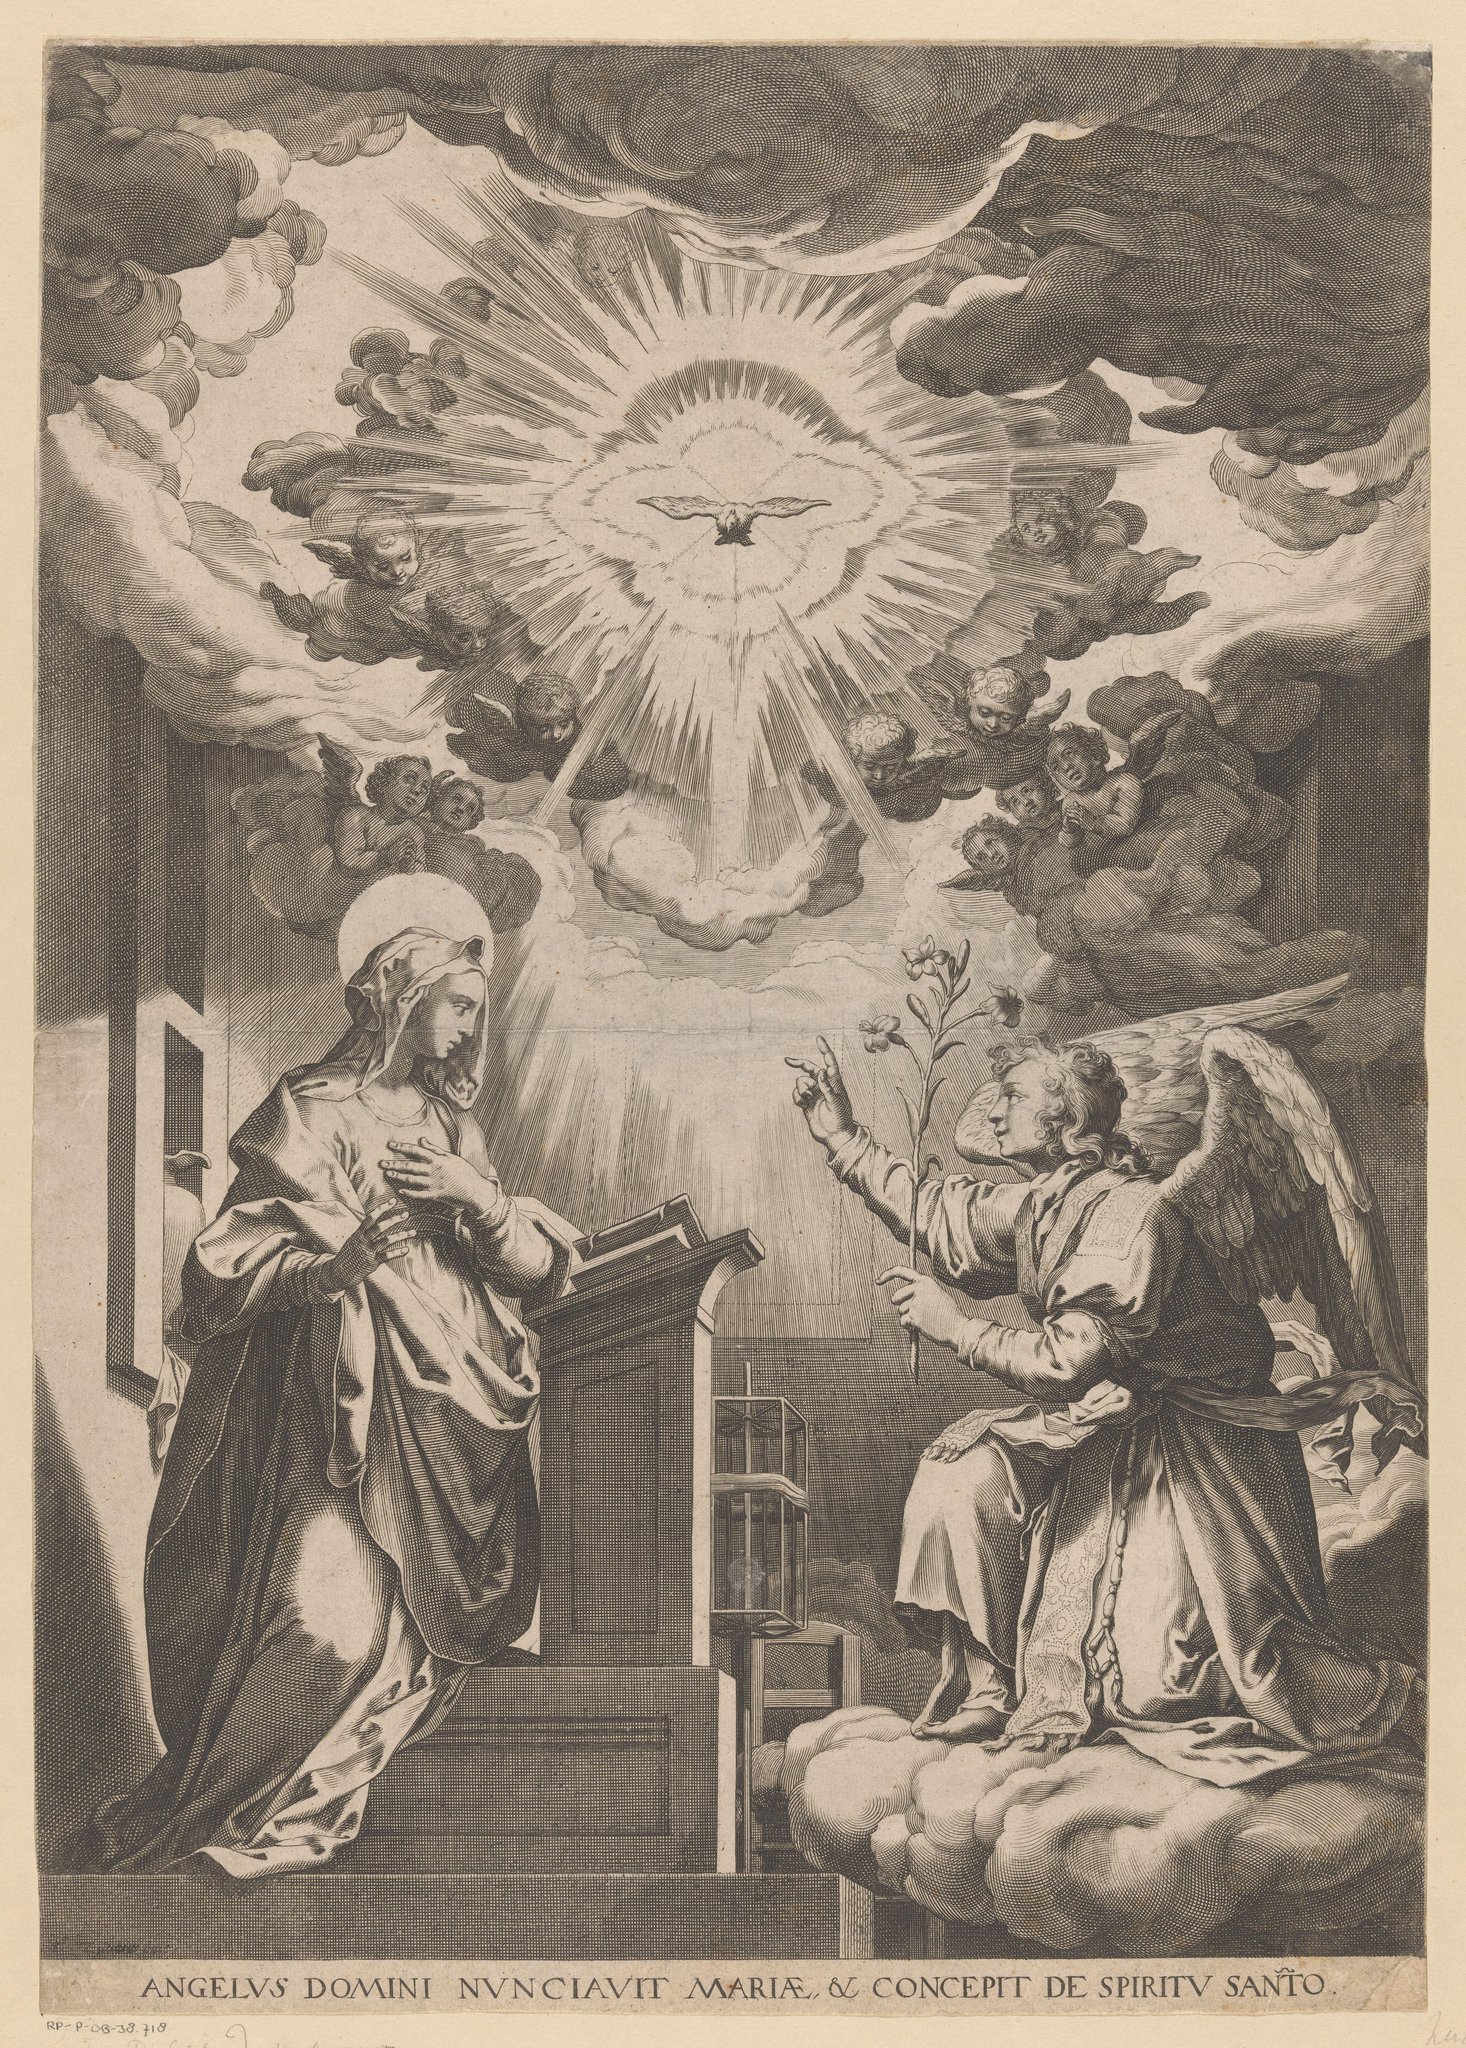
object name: print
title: Annunciatie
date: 1550-1659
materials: paper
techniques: engraving, etching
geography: italy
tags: the annunciation: mary kneeling - aa - mary to the left, the angel to the right, flowers: lily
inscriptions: collector's mark: Lugt 2228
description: De engel Gabriël met een tak met lelies in de hand verschijnt aan Maria en kondigt haar zwangerschap aan. Bovenaan de Heilige Geest als duif, omringd door engelen en cherubijnen. Een regel Latijnse tekst in de ondermarge.